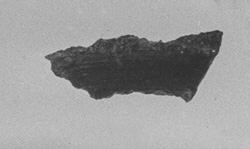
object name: fragment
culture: german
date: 1902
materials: jade